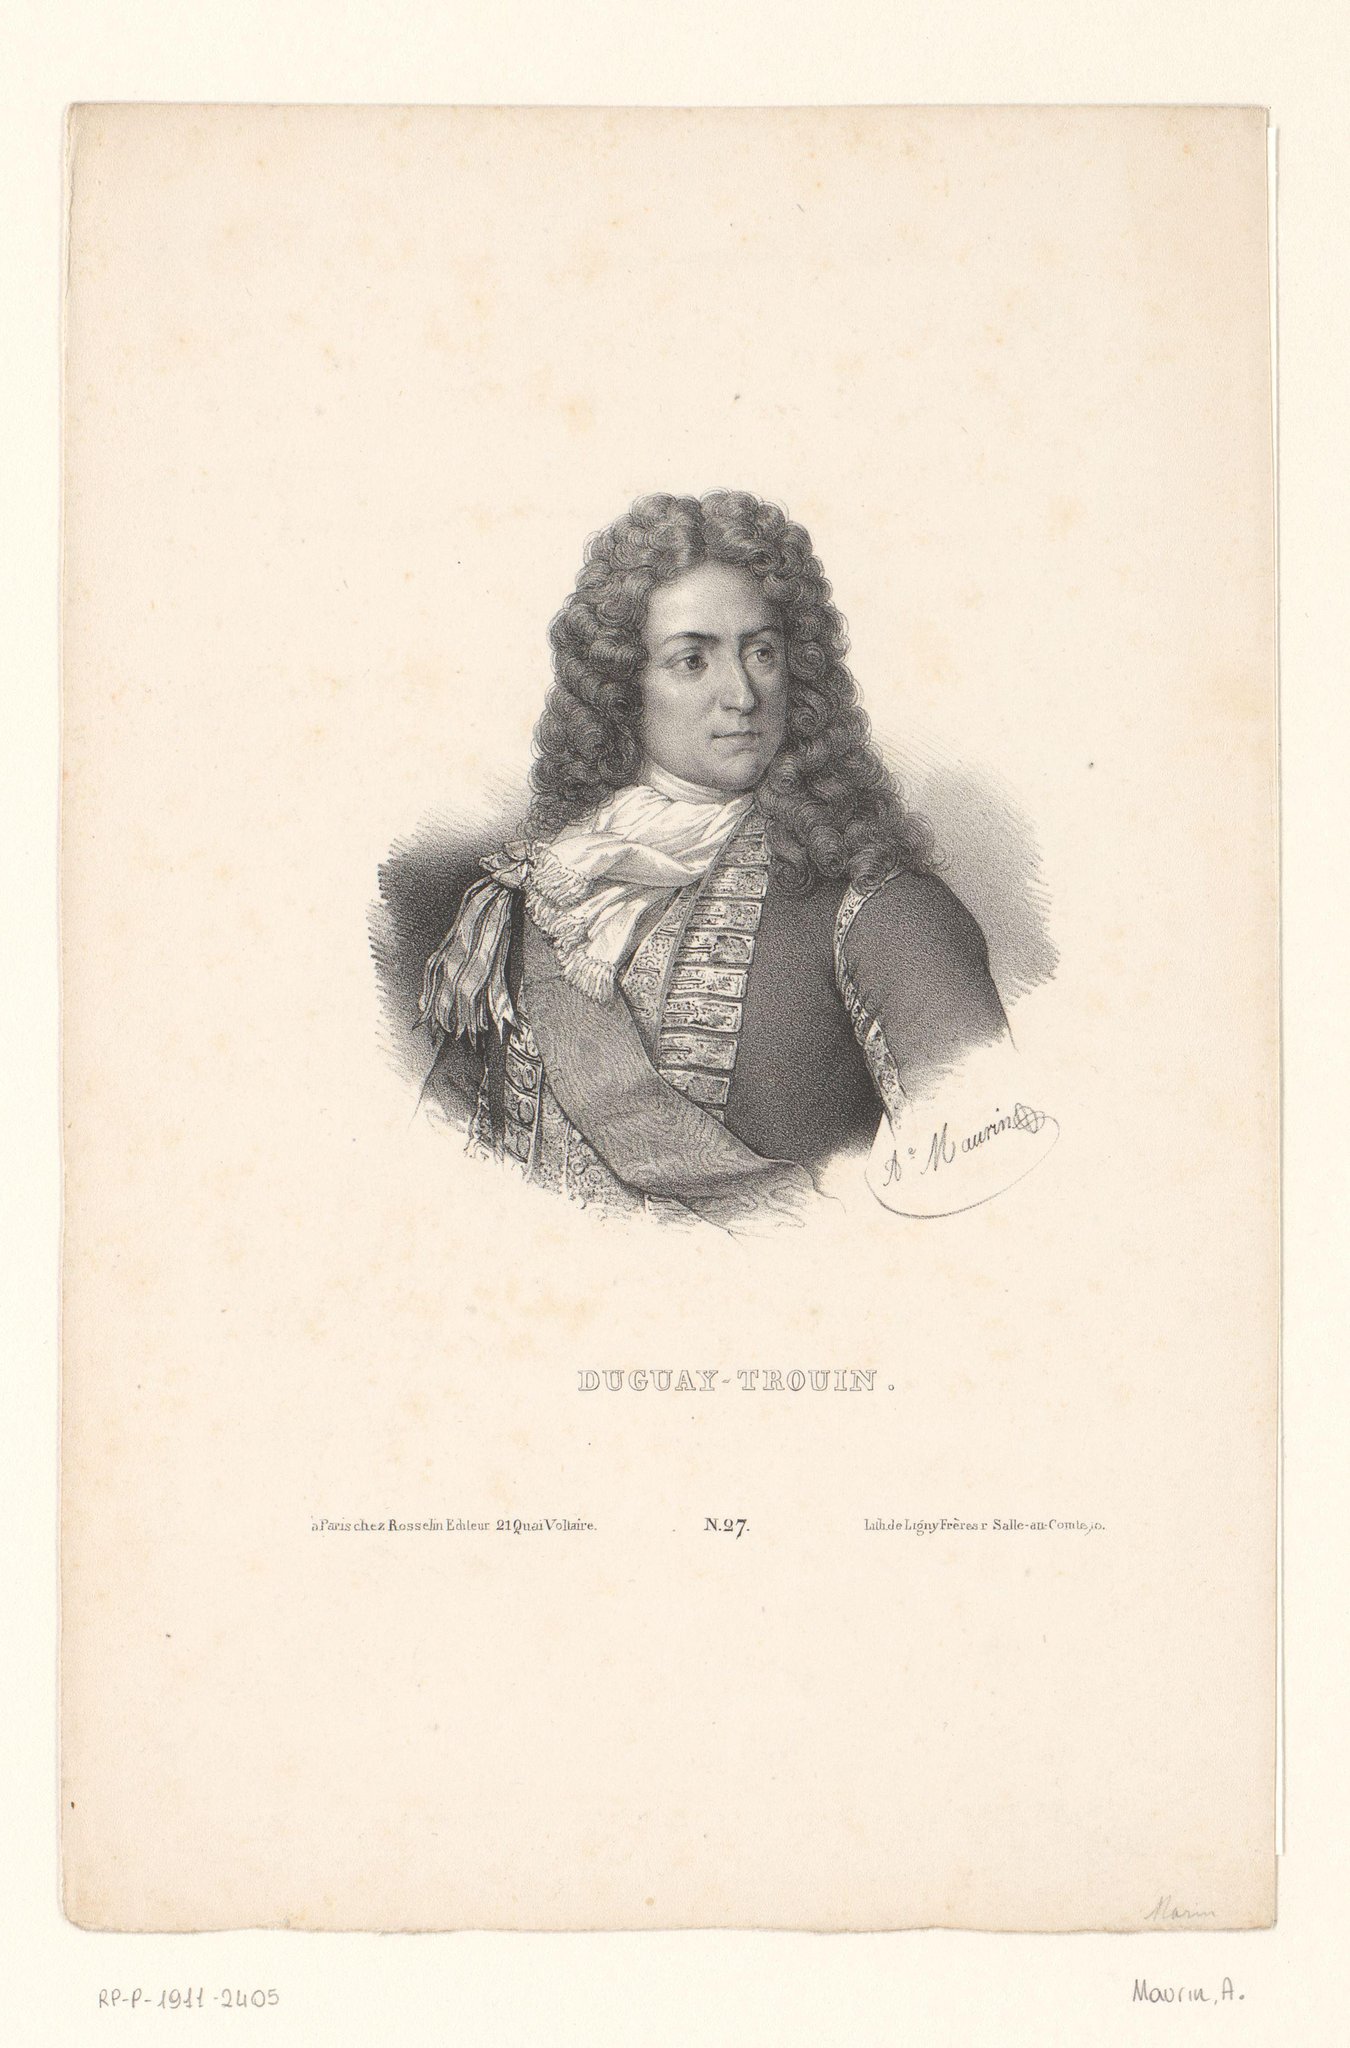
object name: print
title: Duguay-Trouin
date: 1836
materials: paper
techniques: lithograph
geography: paris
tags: historical persons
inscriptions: collector's mark: Lugt 2228